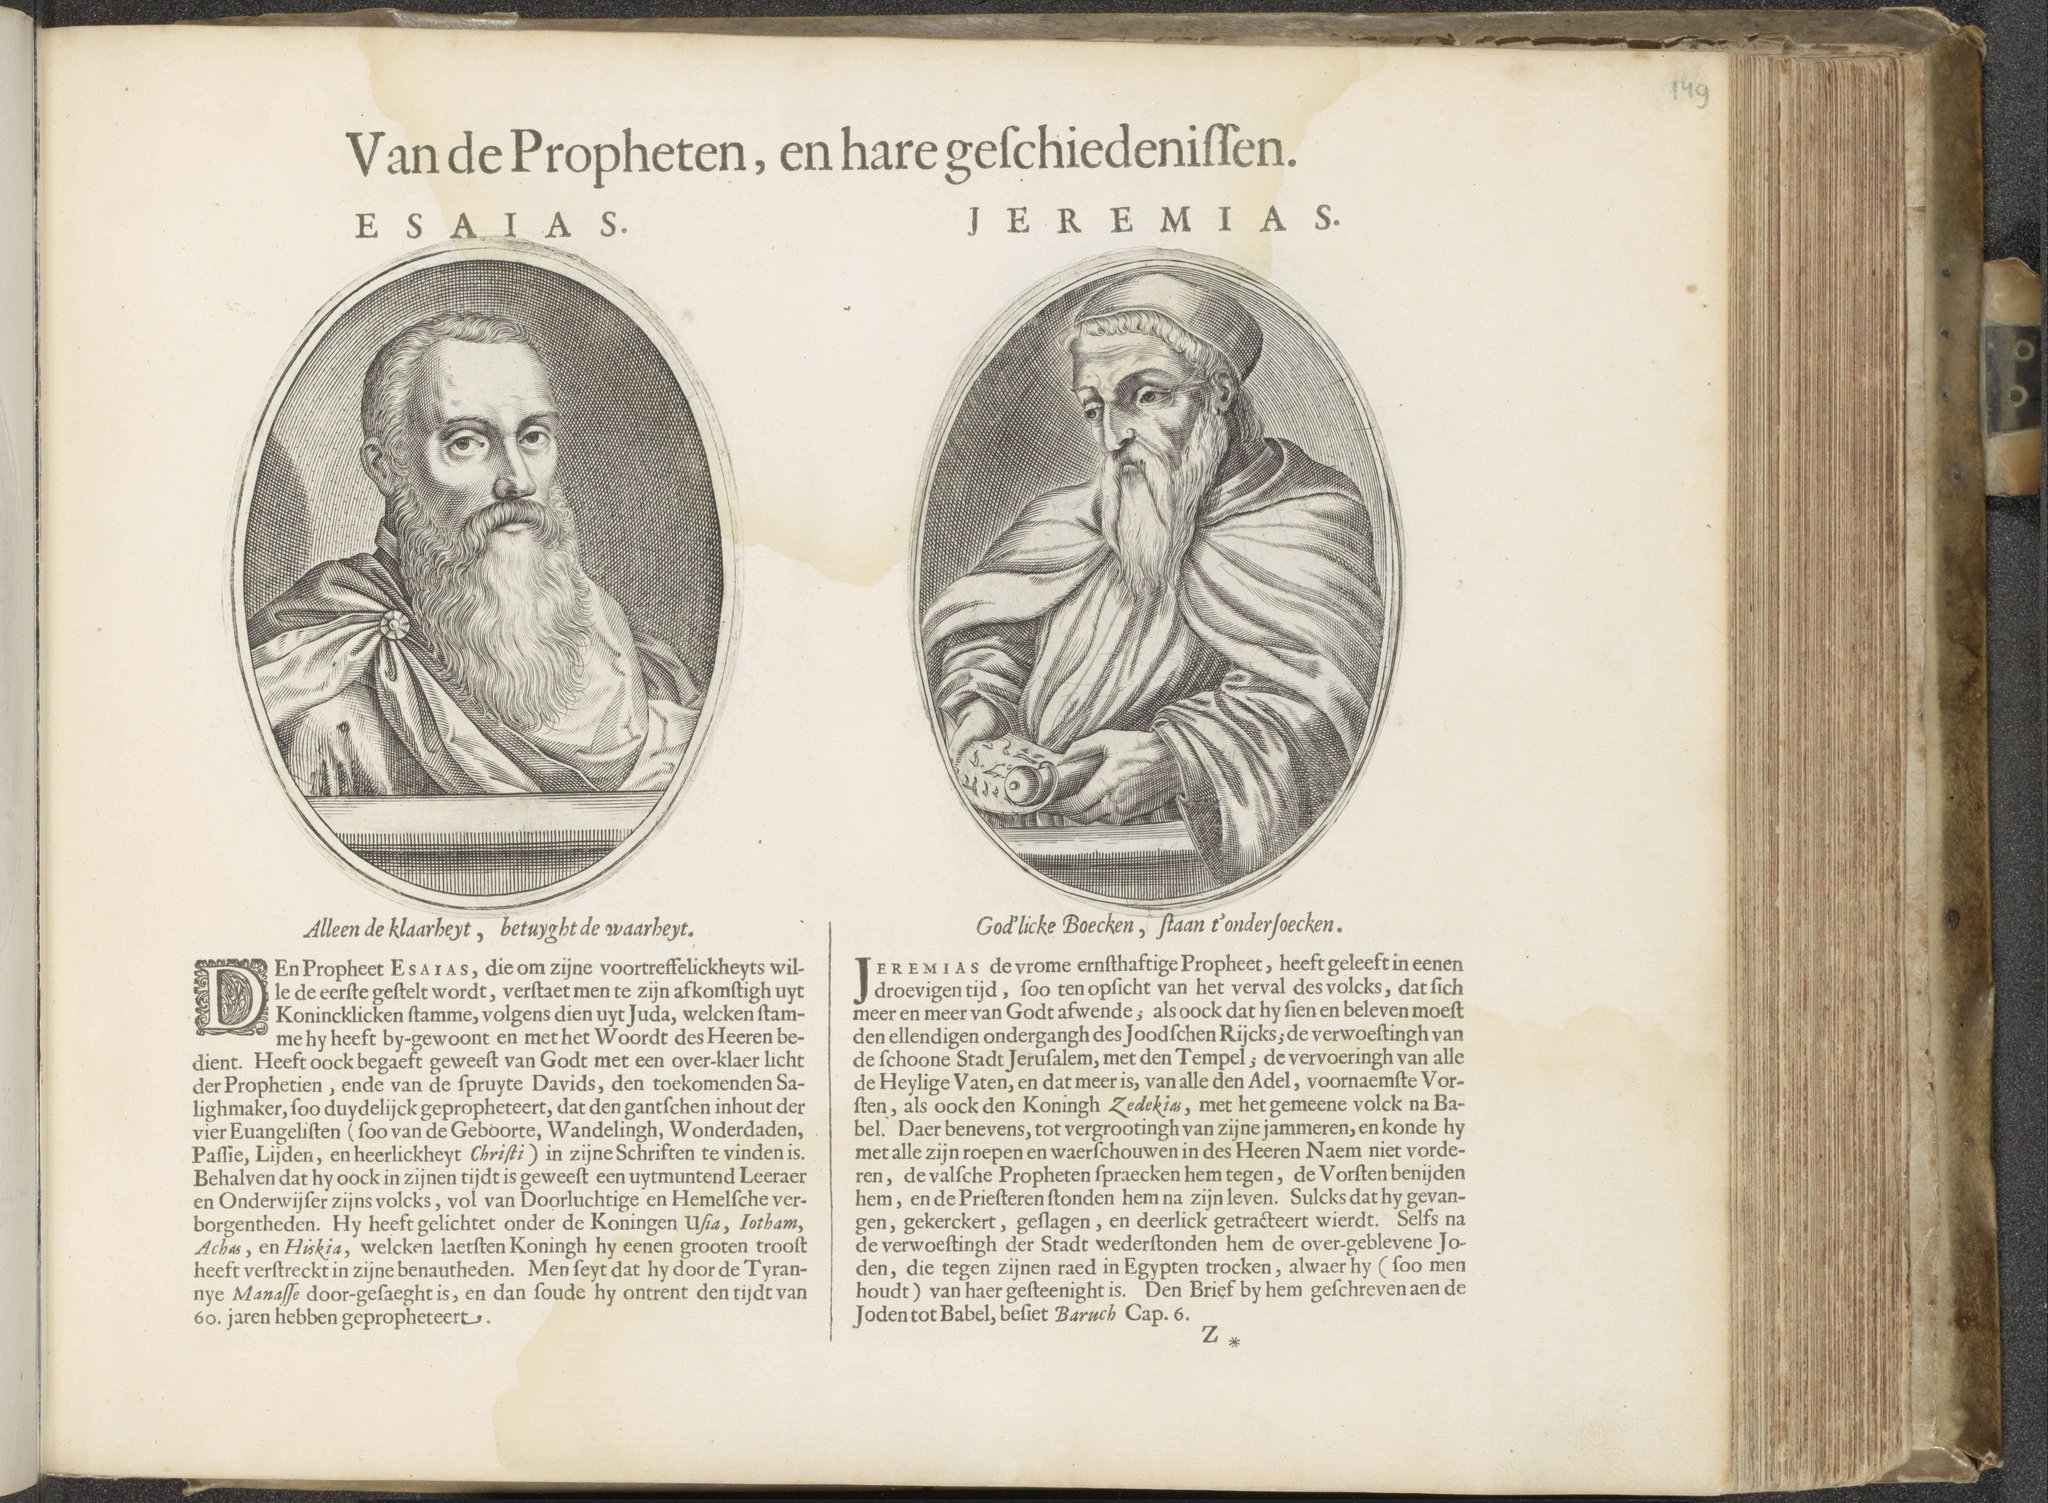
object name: text sheet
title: Van de propheten, en hare geschiedenissen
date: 1610-1625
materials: paper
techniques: engraving, letterpress printing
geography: amsterdam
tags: florence, ontdekkingsreiziger, amerigo vespucci, agostino barbarigo (doge van venetië)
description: Portretten van Agostino Barbarigo en Amerigo Vespucci, in dit album gebruikt als afbeeldingen van respectievelijk de profeten Jesaja en Jeremia. De begeleidende tekst begint met een kleine gedecoreerde initiaal D. Het blad maakt deel uit van een album.